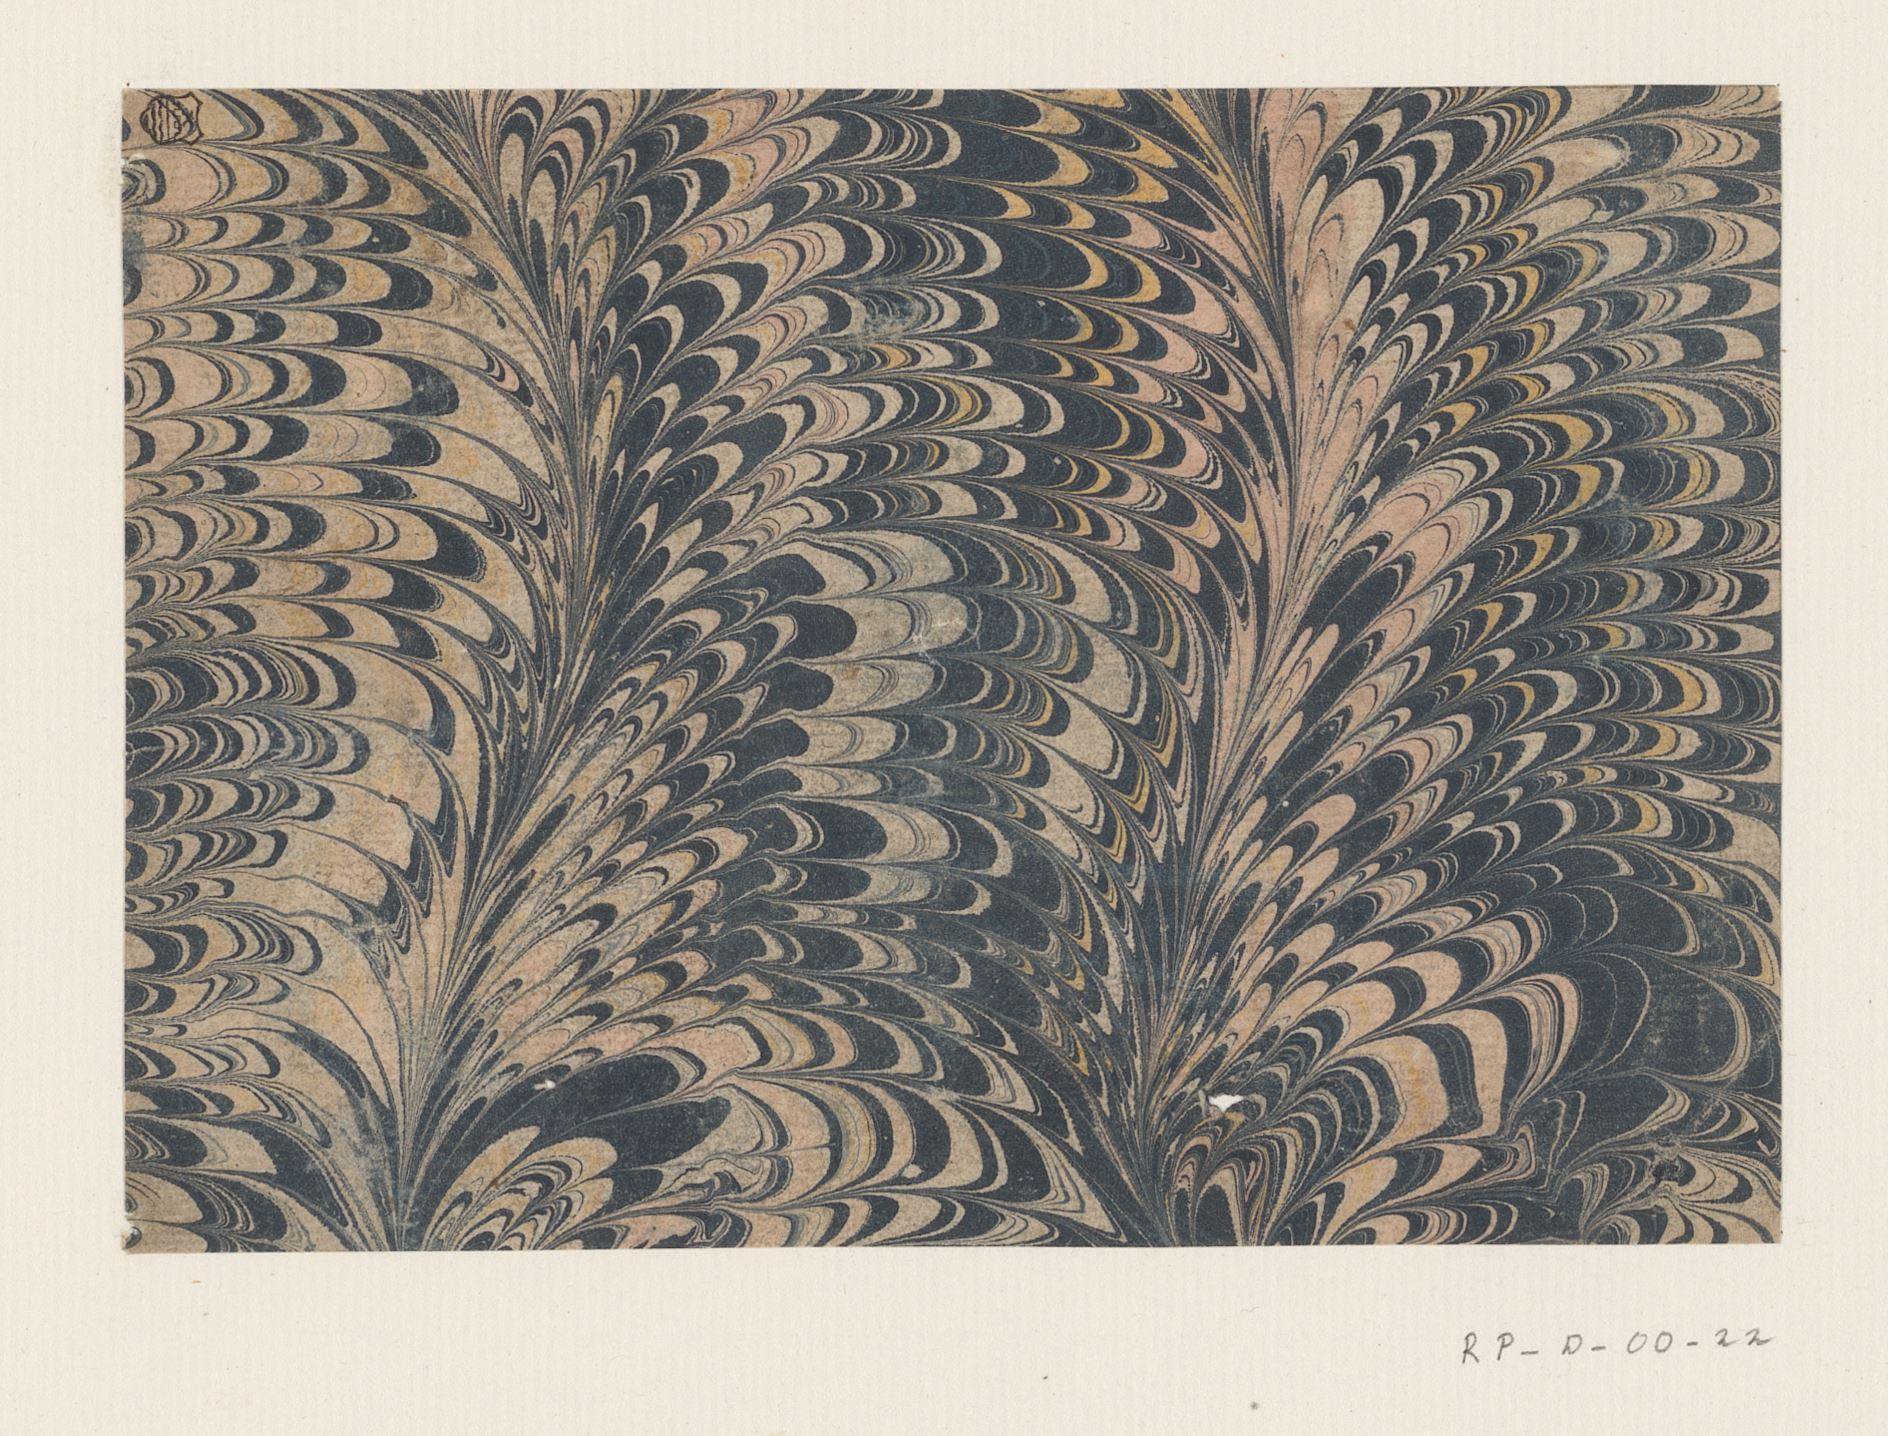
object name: marbled paper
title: Golfkammarmer in blauw, geel en roze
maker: Anonymous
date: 1700-1850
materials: paint, paper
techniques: marbled paper